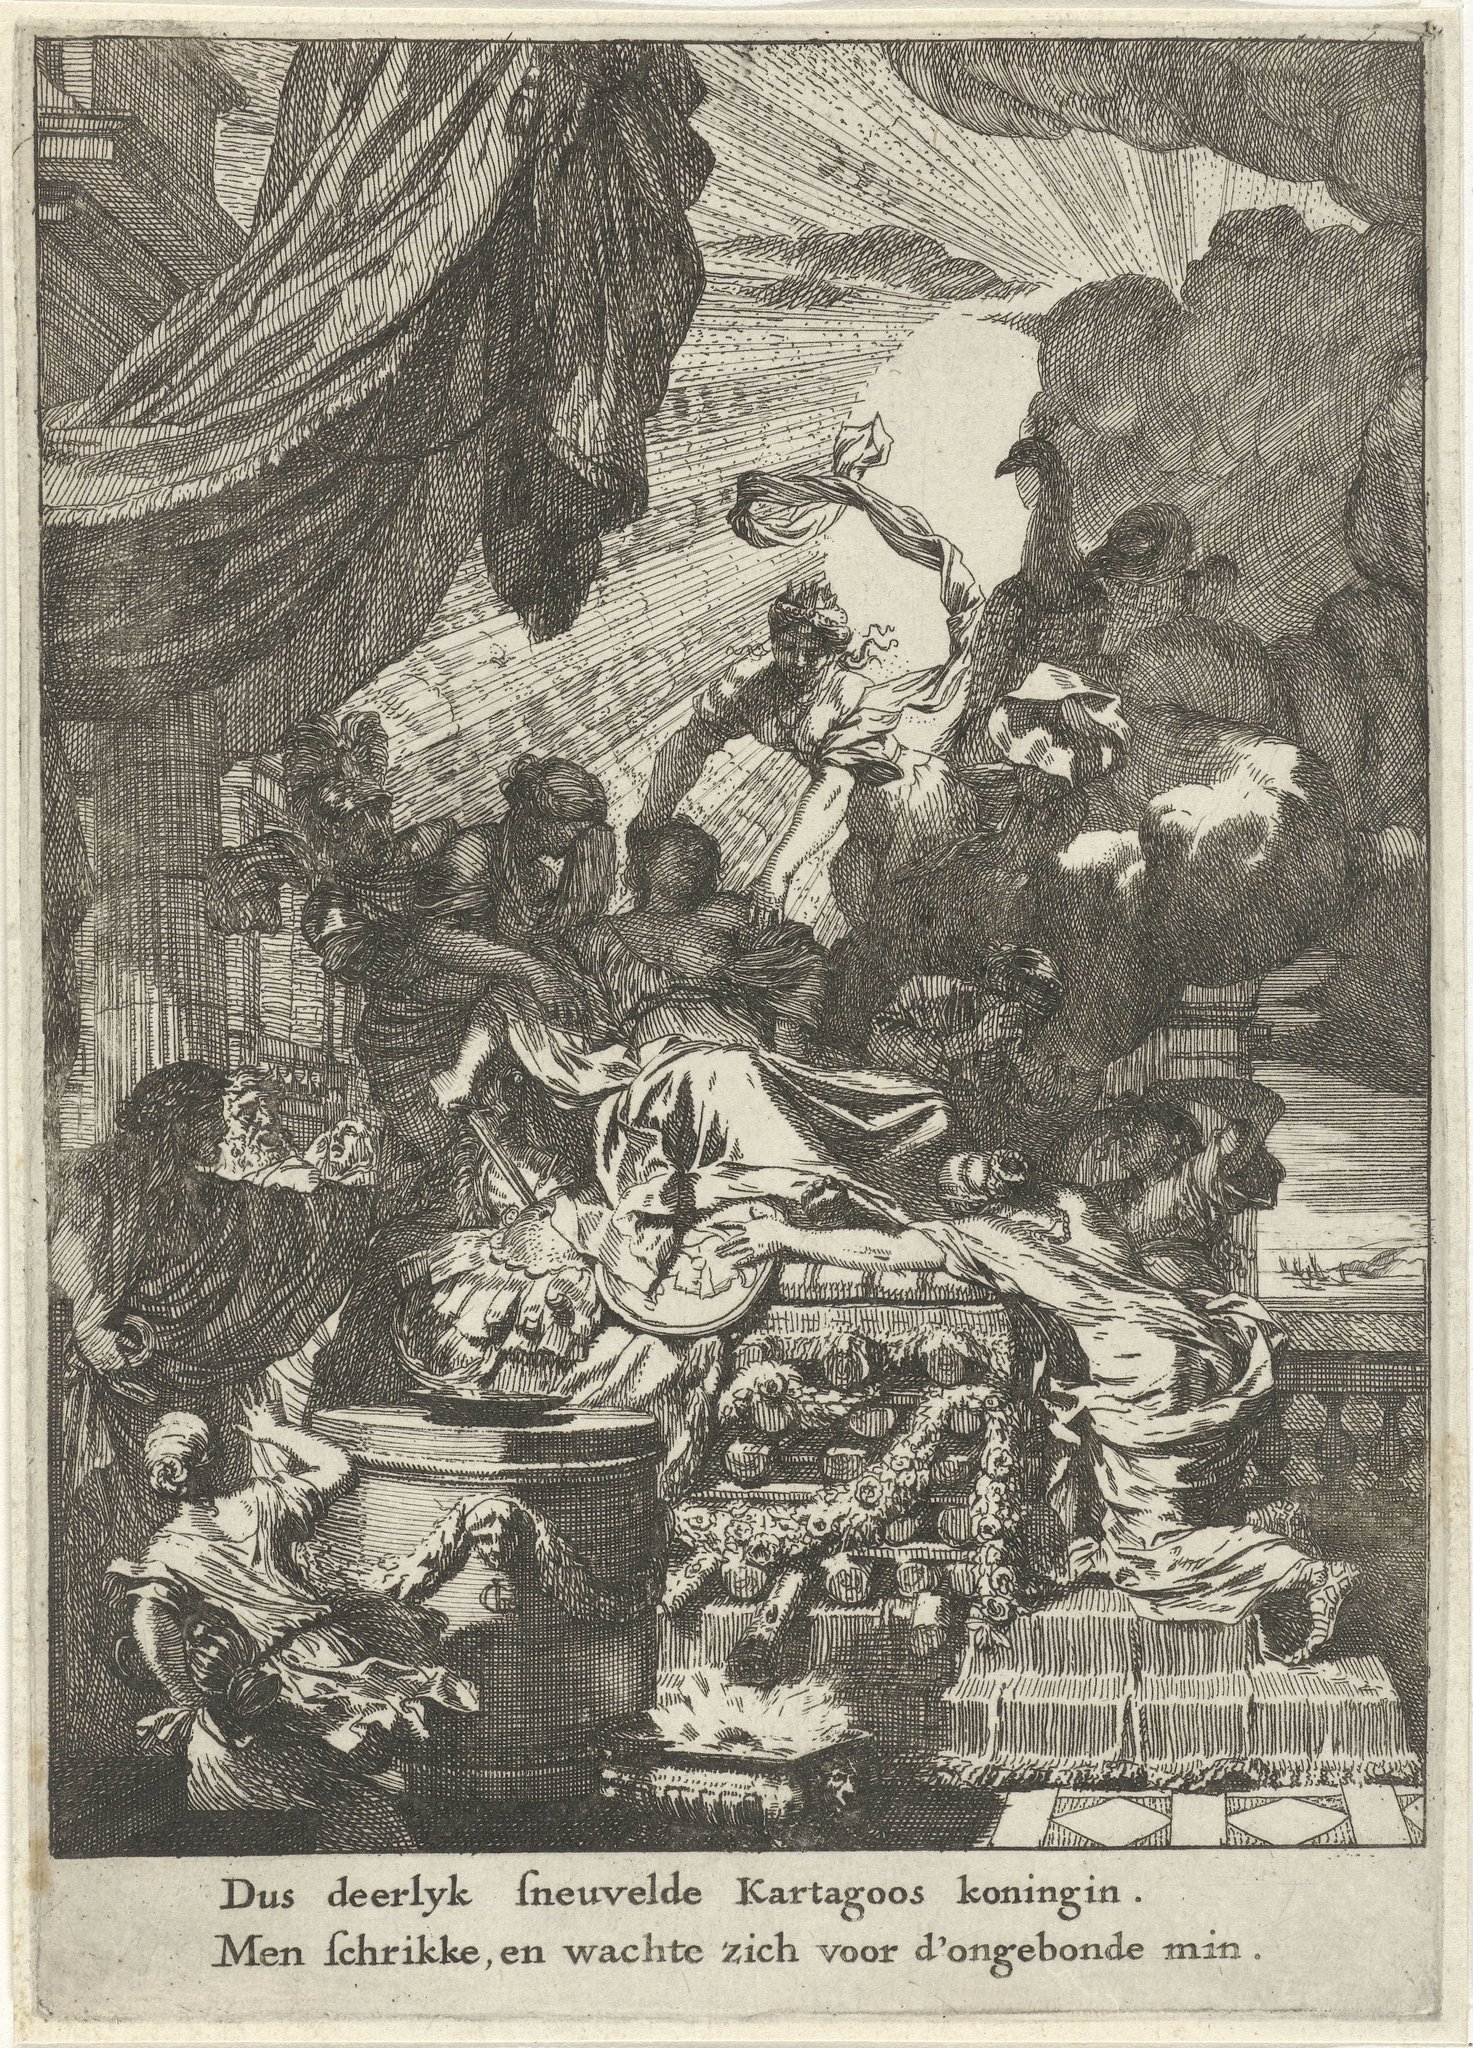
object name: print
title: Dood van Dido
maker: gerard de lairesse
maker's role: draughtsman, painter, print maker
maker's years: 1641-1711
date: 1668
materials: paper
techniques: etching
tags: (story of) dido - death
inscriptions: collector's mark: Lugt 240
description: Dido heeft zichzelf met het zwaard van Aeneas doorboord nadat haar geliefde per boot is vertrokken. Ze ligt op de brandstapel, opgebouwd uit bezittingen van Aeneas, die zij zelf heeft laten oprichten. Iris, de vrouwelijke boodschapper van Juno, is achter Dido verschenen om een haarlok af te knippen. Links staat Dido's zuster Anna in grote wanhoop. In de marge staat een tweeregelig onderschrift in het Nederlands. Deze illustratie is vervaardigd bij het derde bedrijf van het treurspel "Didoos Doot" (1668), geschreven door Andries Pels. De prent maakt deel uit van een vierdelige serie met scènes uit dit treurspel.